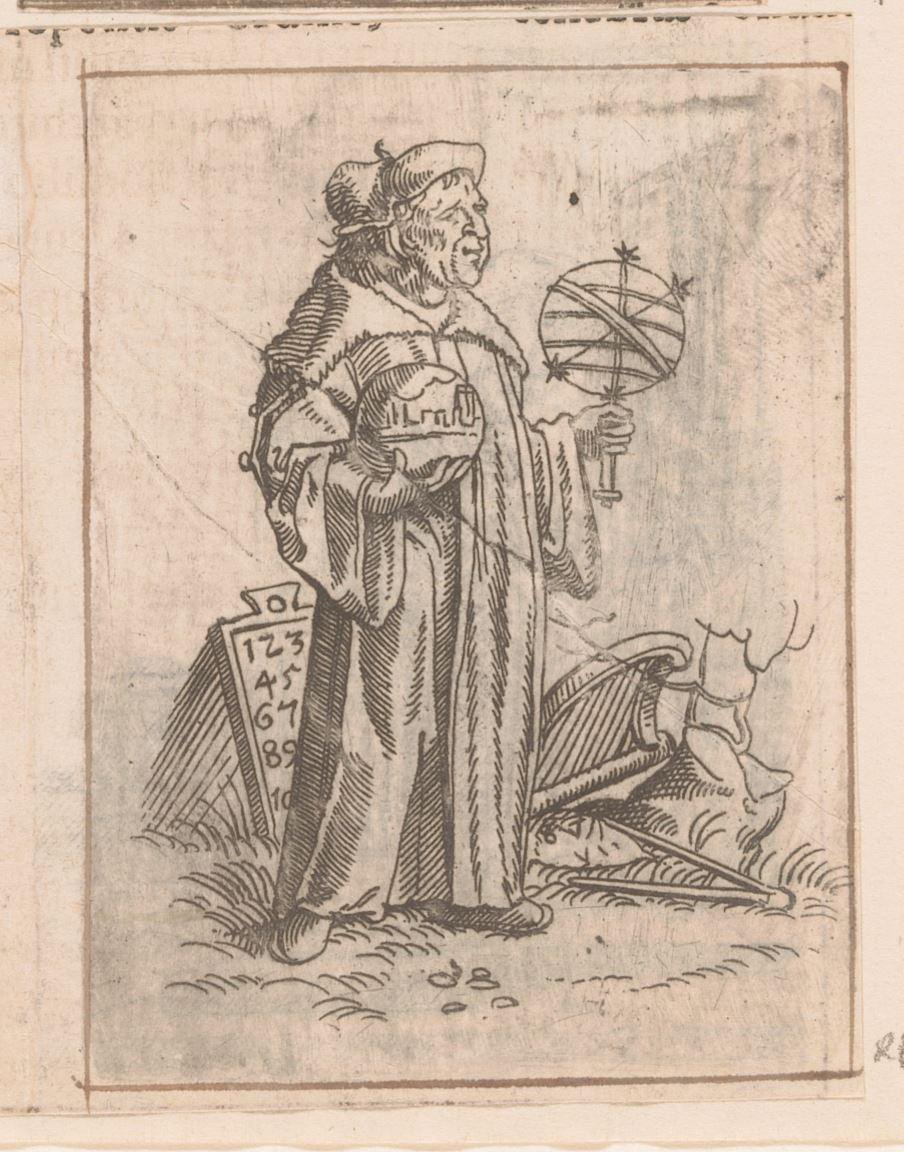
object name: print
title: Humanistische wetenschapper met wetenschappelijke instrumenten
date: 1516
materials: paper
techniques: etching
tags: rotterdam, desiderius erasmus, science and technology, scholar, philosopher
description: Prent afkomstig uit: Erasmus, Desiderius. Morias enkomion (...). Bazel: Johann Rudolf Genath, 1676. De prenten hierin zijn naar tekeningen die Hans en Ambrosius Holbein maakten voor de theoloog Oswald Myconius in diens uitgave van de Moriae encomium (Lof der Zotheid) van 1516.